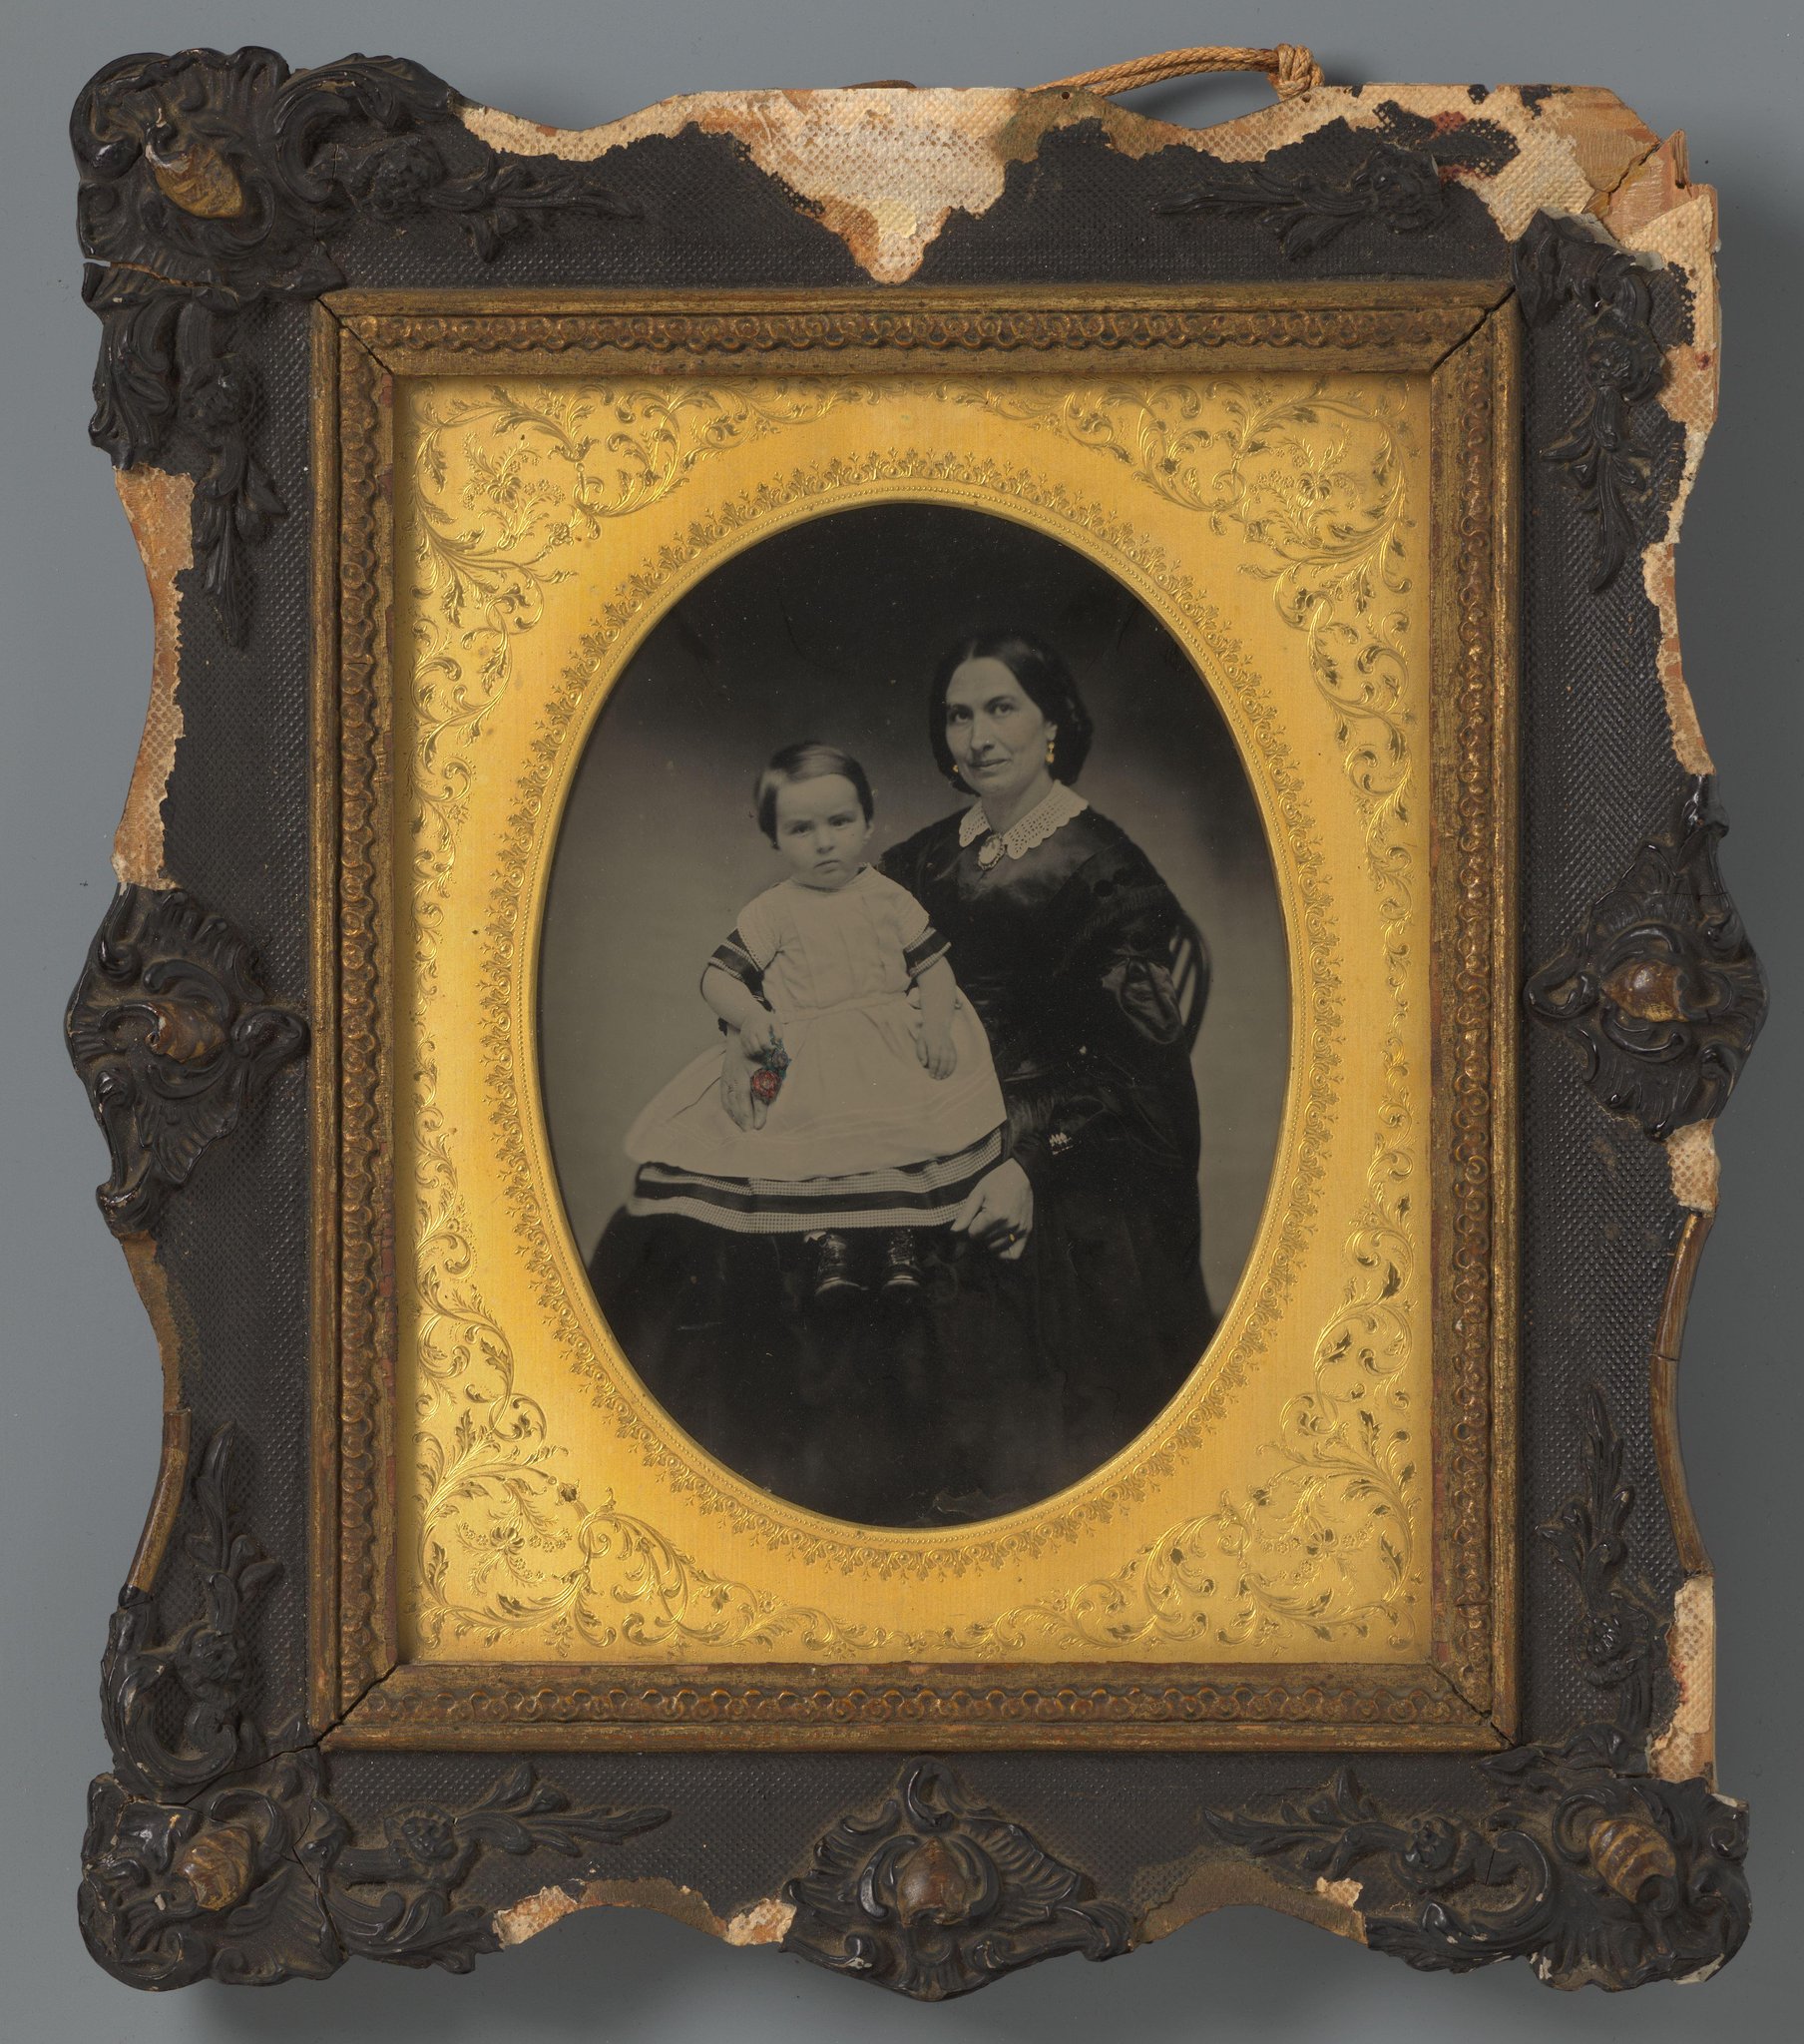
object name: frame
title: Portret van onbekende vrouw met kind op schoot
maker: Anonymous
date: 1855-1870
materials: glass, metal, paper, wood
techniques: ambrotype, hand coloring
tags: historical persons - bb - woman, toddler (female), mother and baby or young child